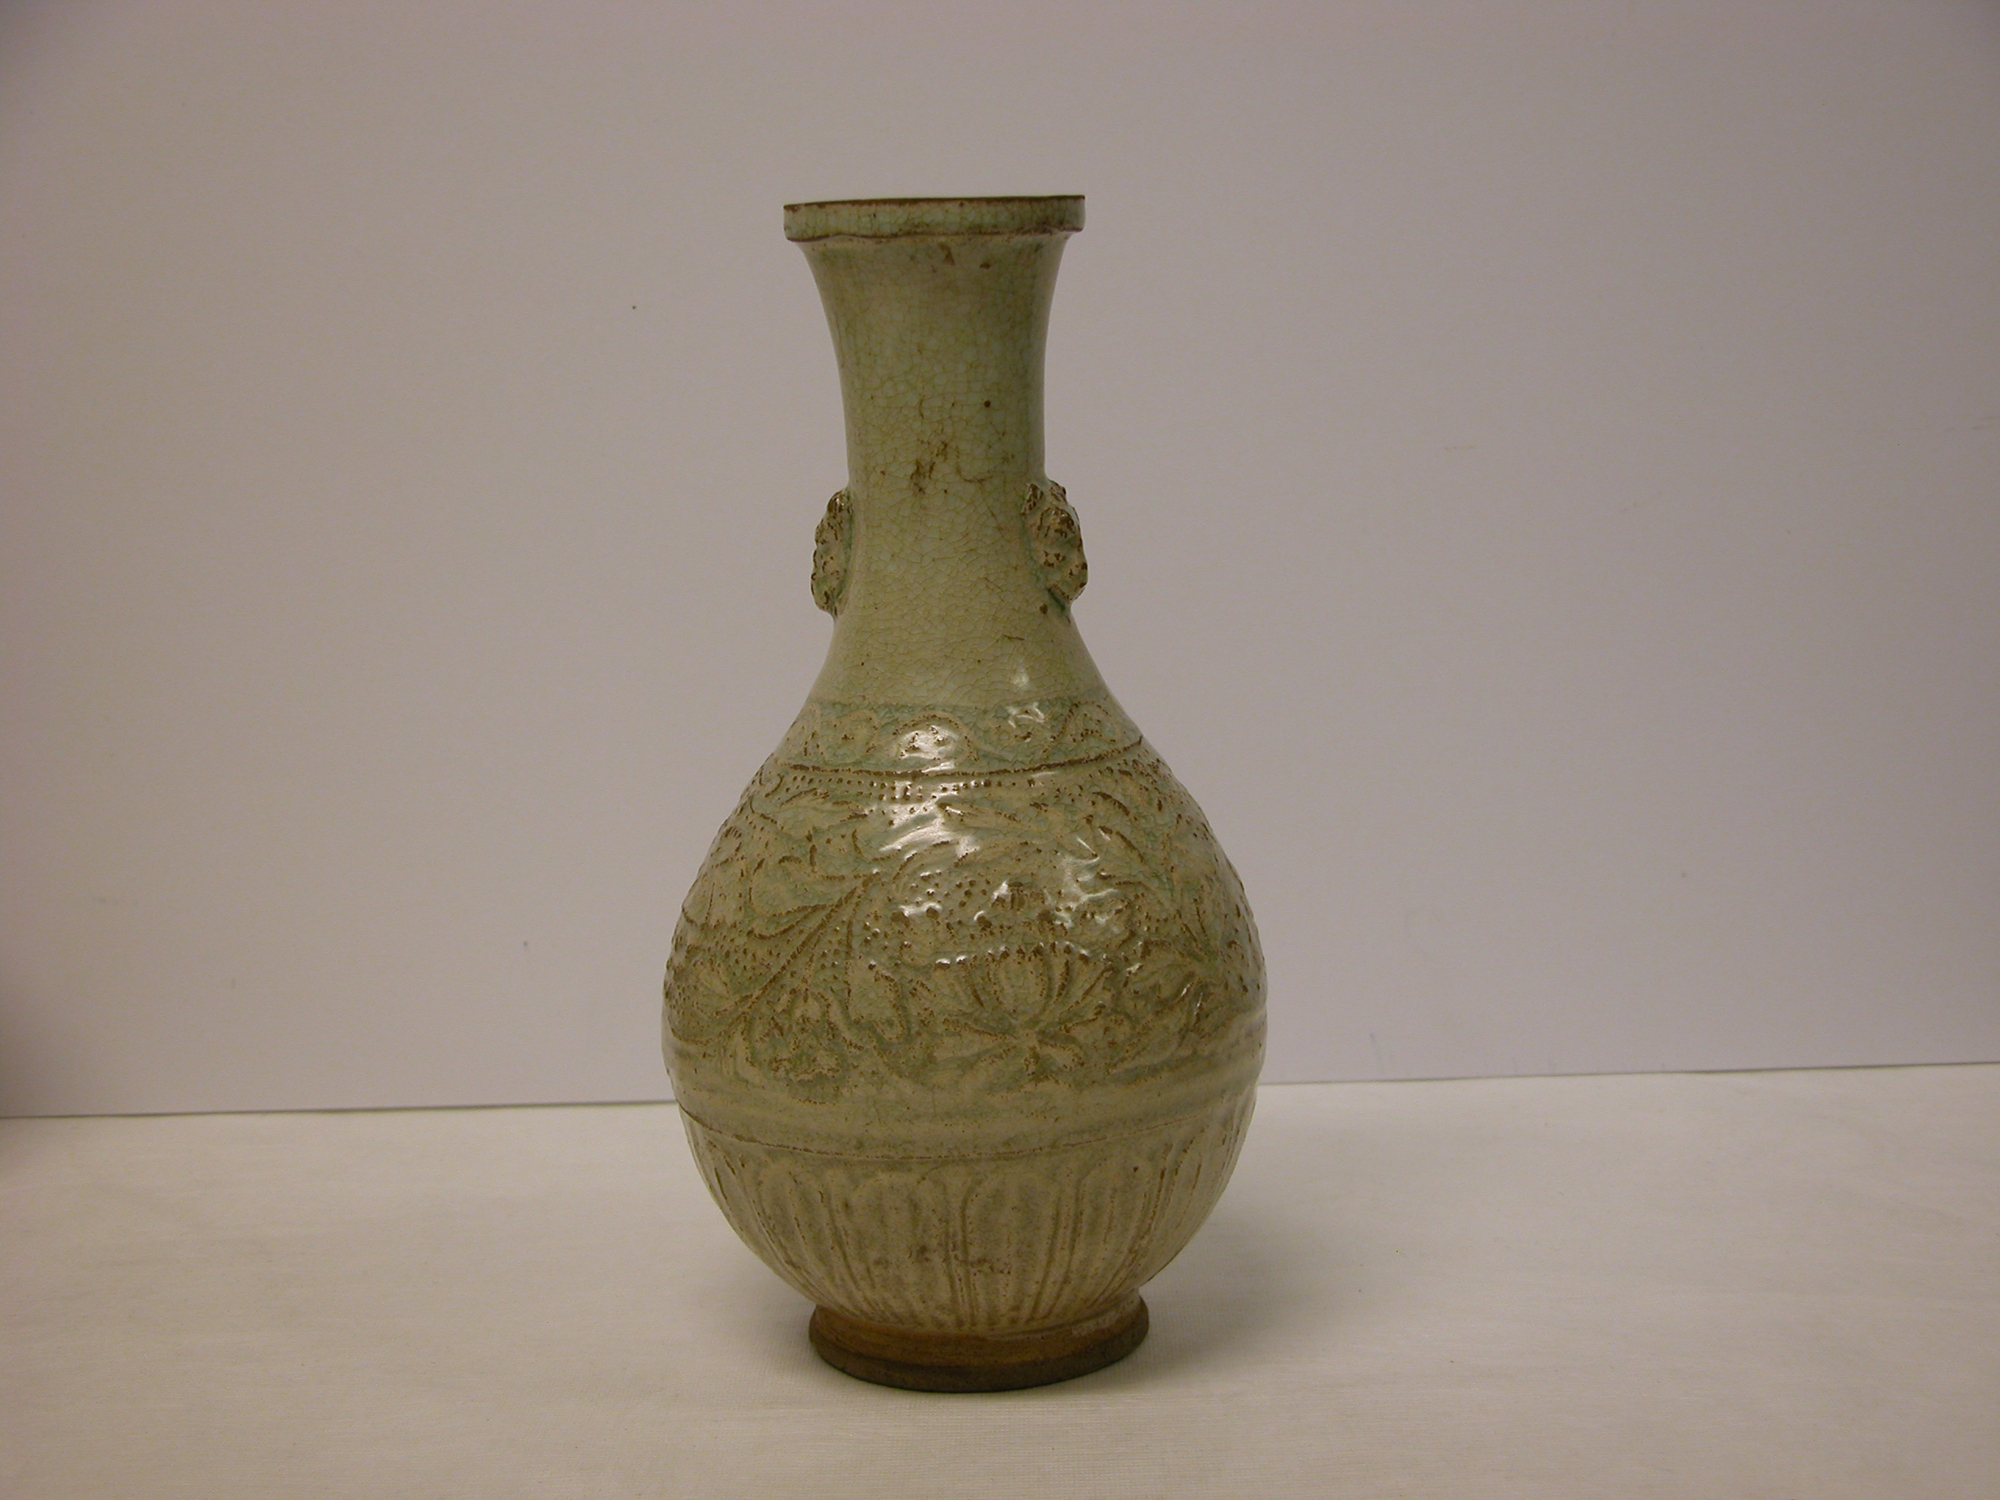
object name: vase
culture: chinese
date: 960-1279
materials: glaze, porcelain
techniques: carving